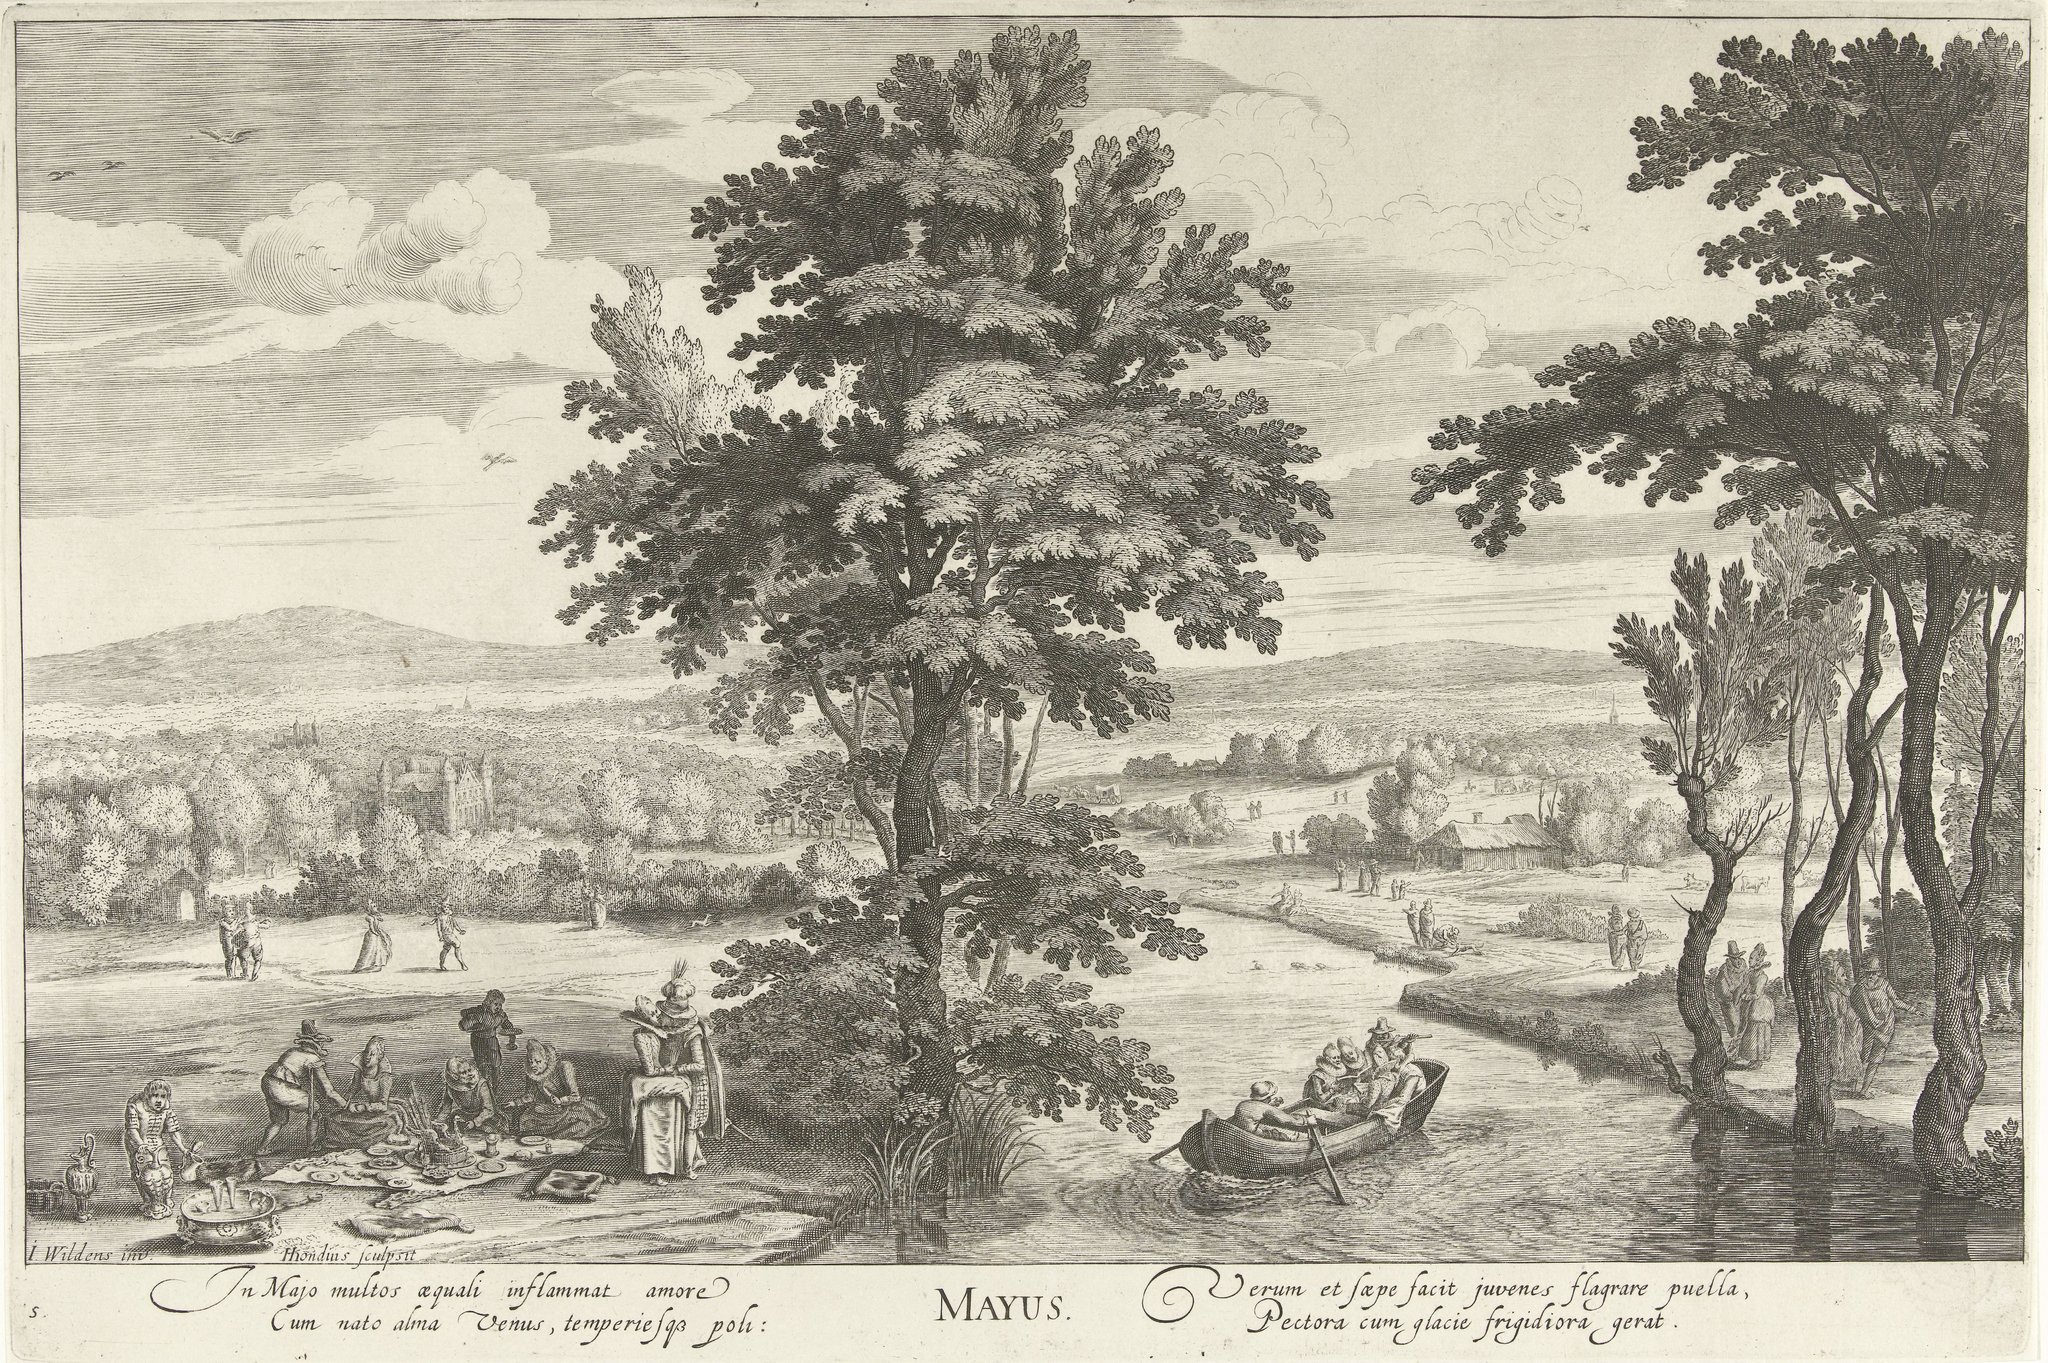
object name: print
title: De twaalf maanden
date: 1614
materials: paper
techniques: engraving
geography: the hague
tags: may and its 'labours', picnic, alfresco, 'déjeuner sur l'herbe', open-air recreation, rowing, canoeing, etc. (sport), landscape symbolizing may (+ with scenes showing human occupations ~ seasons and months)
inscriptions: number: ‘5’, collector's mark: Lugt 240, title: ‘MAYUS’, signature: ‘Hhondius sculpsit.’, caption: ‘In Majo multos...frigidiora gerat.’, signature: ‘I.Wildens inv.’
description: Landschap met grote boom in het midden op de voorgrond, rechts een rivier en links een weiland met bosrand. Op de rivier een roeibootje met zingend gezelschap. Op de voorgrond een picknick van een elegant gezelschap. Geheel rechts wandelende paren tussen de bomen. Onder de voorstelling een tekst in het Latijn. Prent uit een serie van de twaalf maanden.